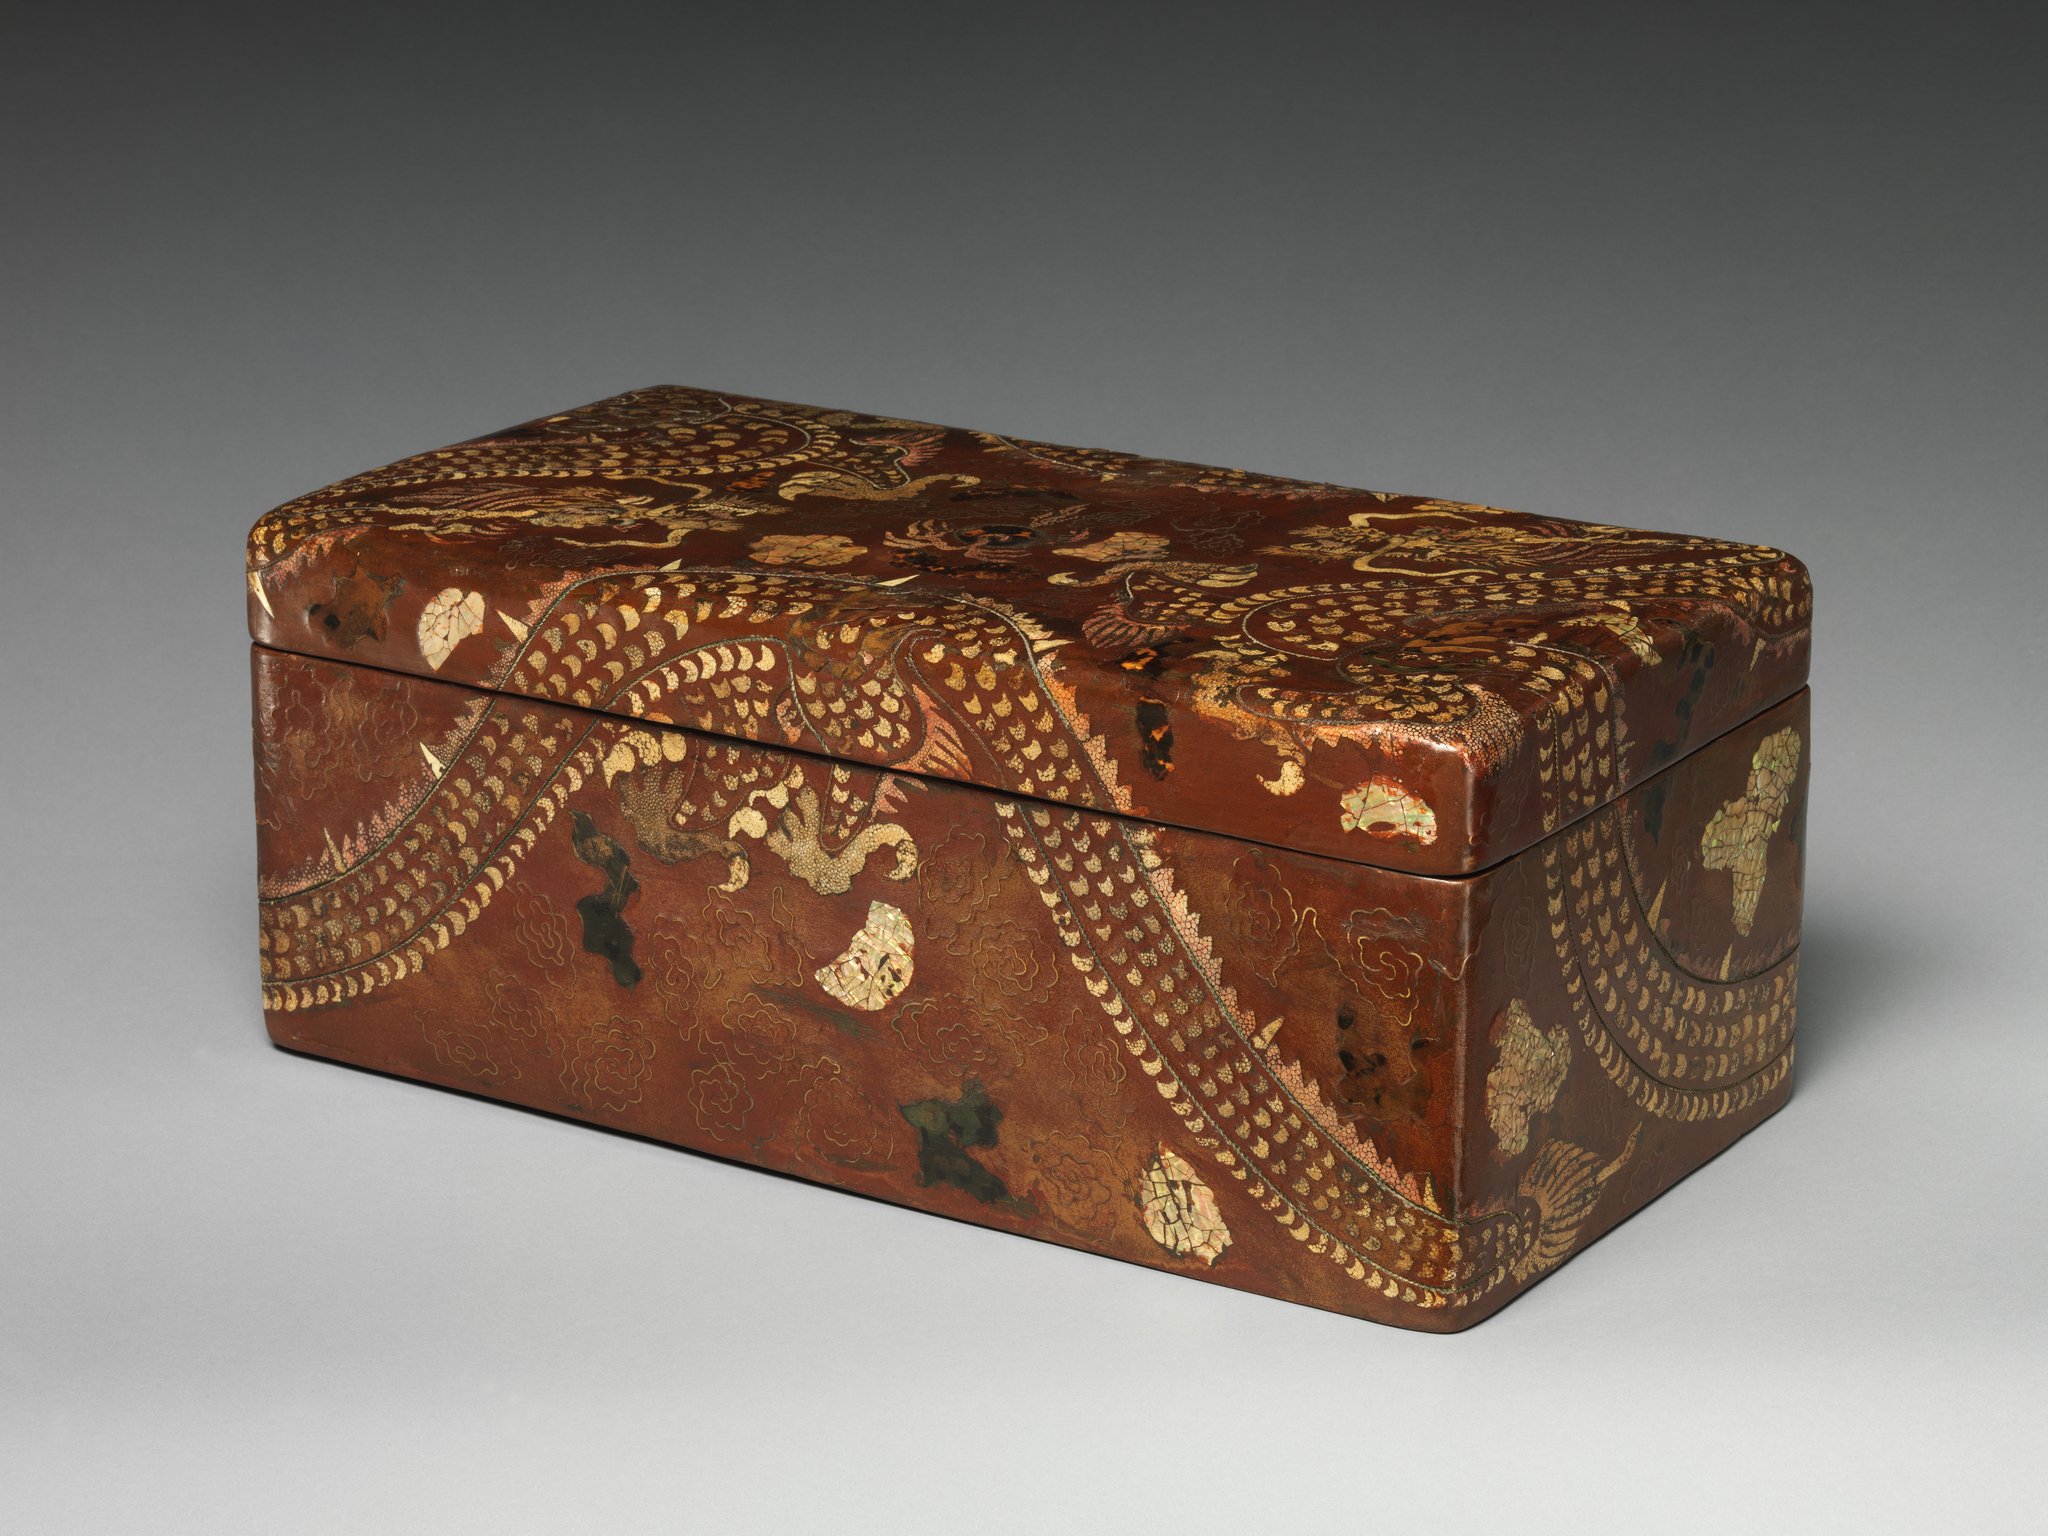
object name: box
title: Box decorated with dragons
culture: korean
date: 1801-1900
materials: brass, lacquer, mother of pearl, skin, shell, metal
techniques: inlay